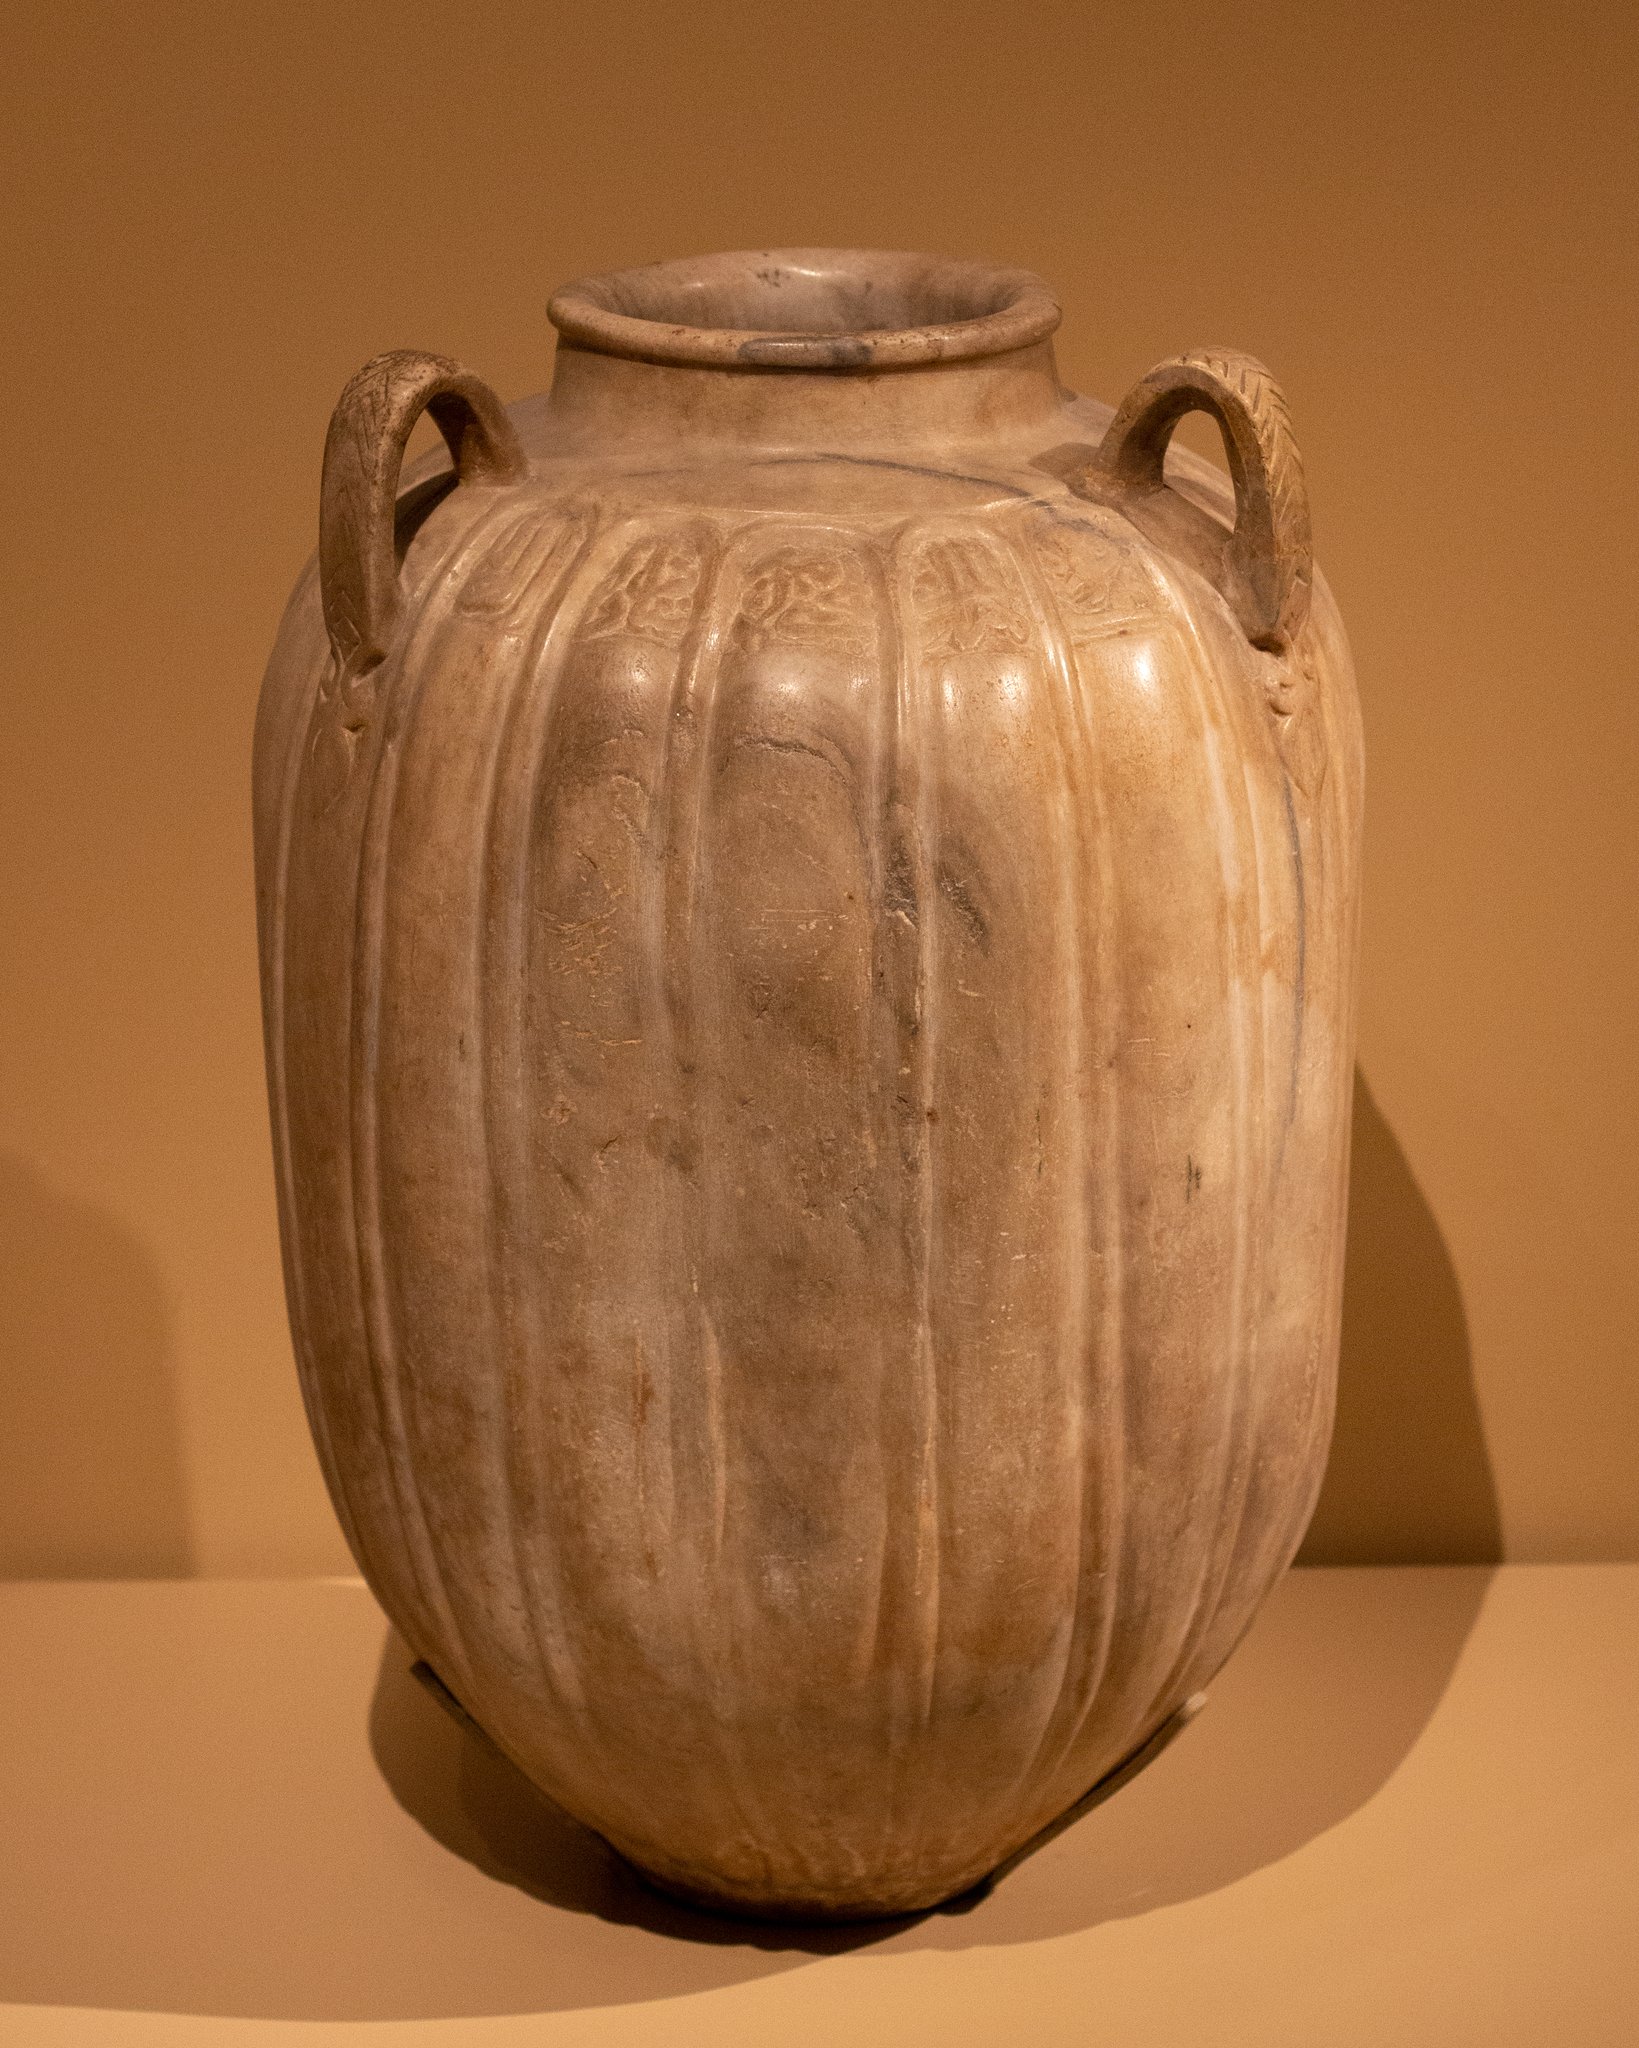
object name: jar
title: Marble Jar of Zayn al-Din Yahya Al-Ustadar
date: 1444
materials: marble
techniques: carving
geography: egypt